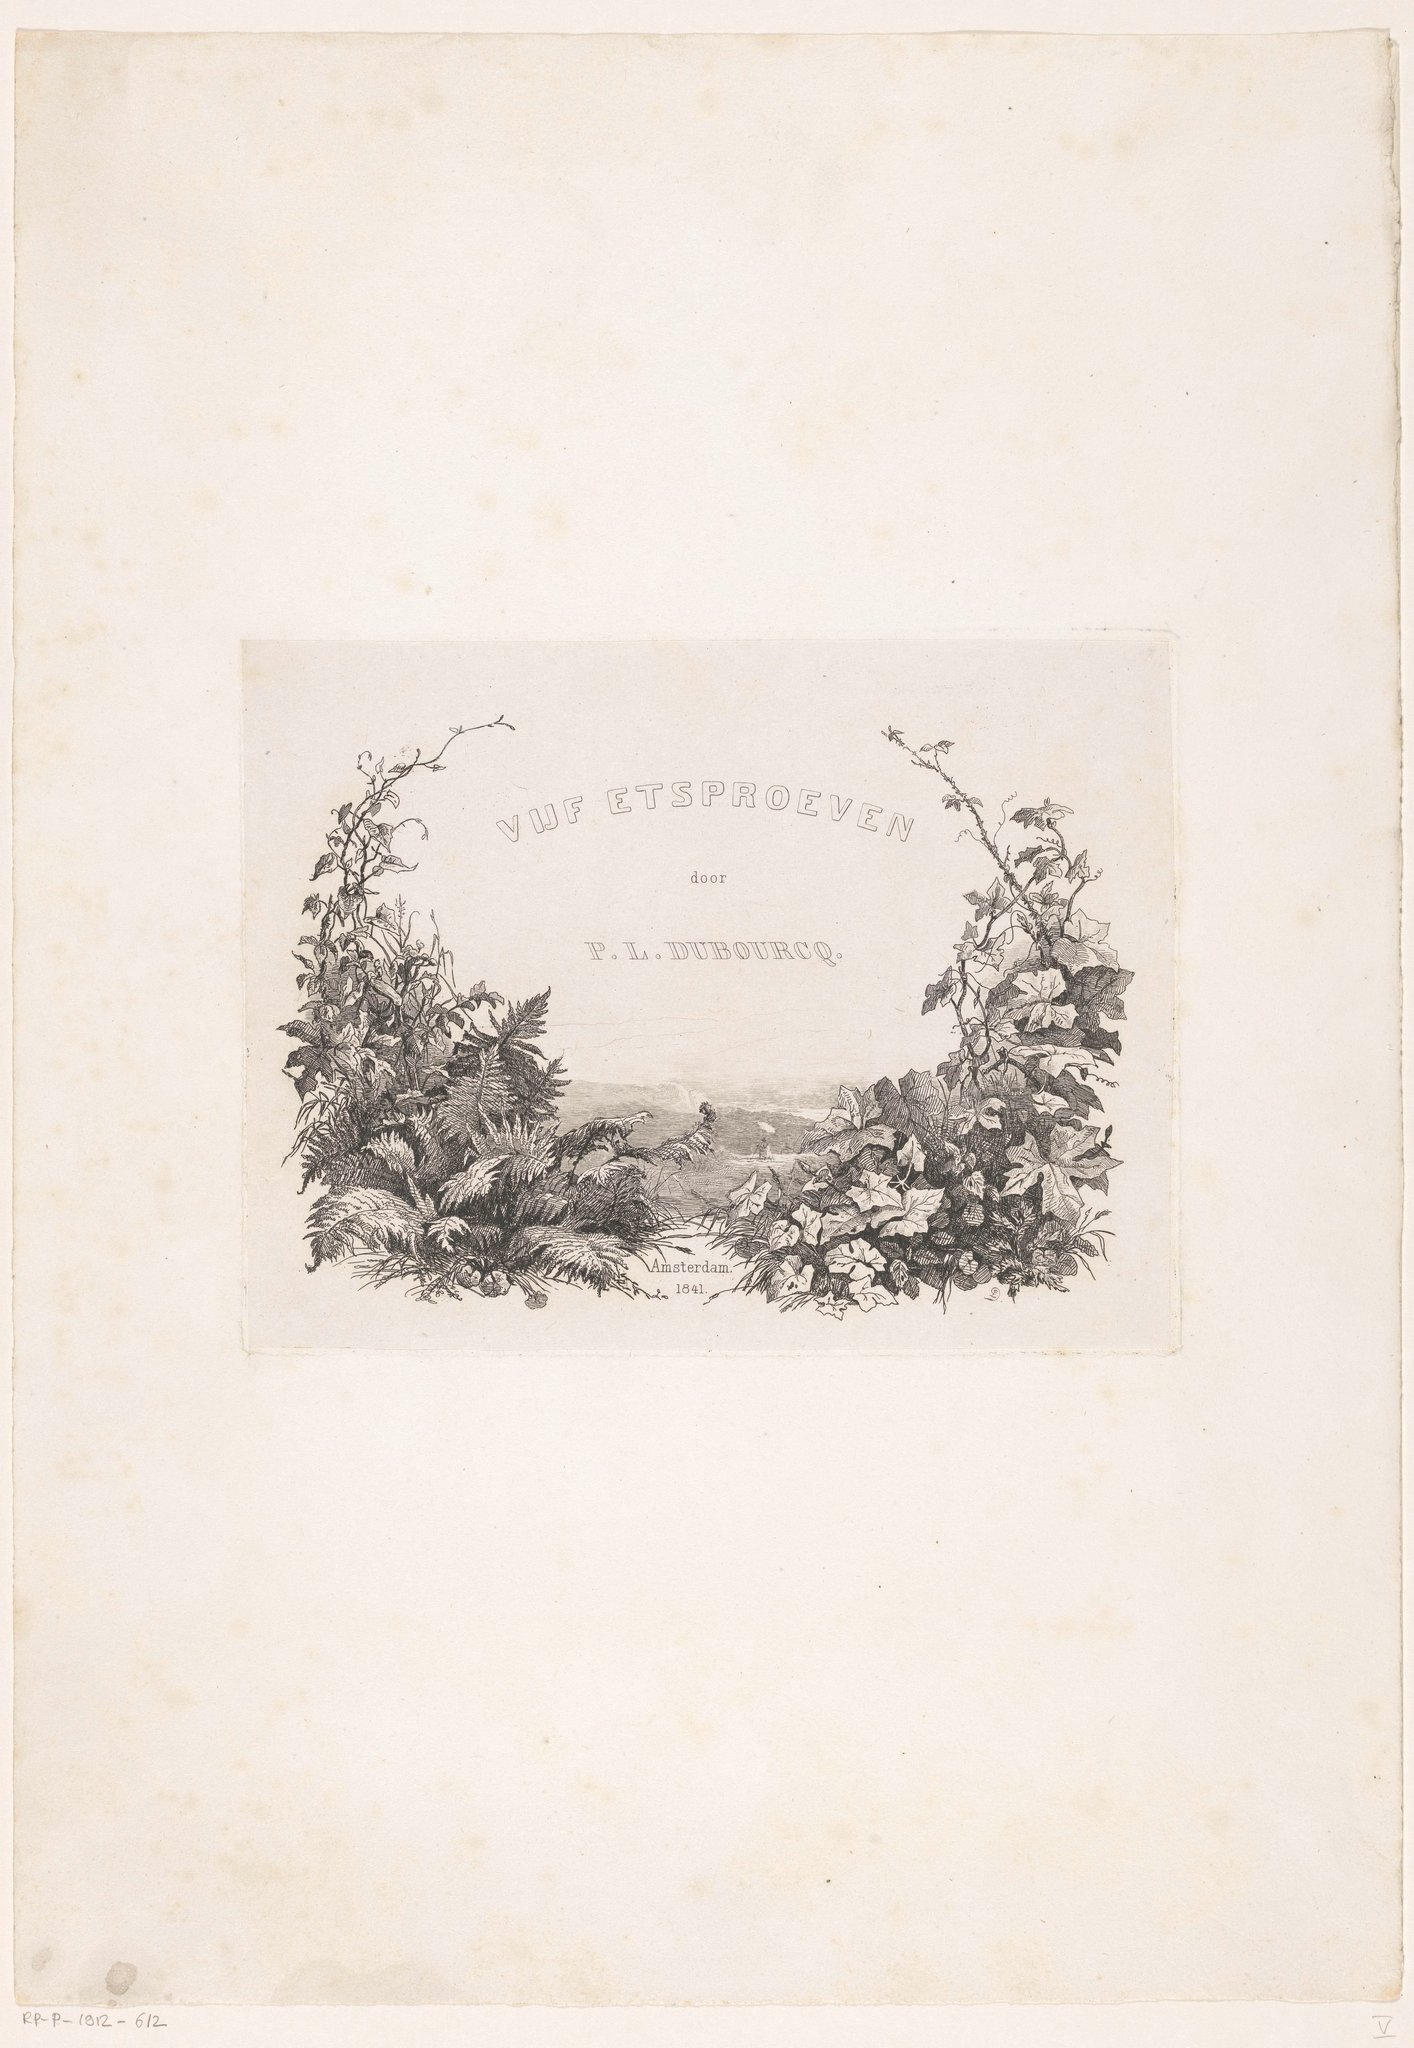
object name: print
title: Kunstenaar aan het werk in de natuur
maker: pierre louis dubourcq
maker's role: draughtsman, painter, print maker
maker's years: 1815-1873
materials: paper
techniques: etching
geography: netherlands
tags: working situations of artist - bb - out of doors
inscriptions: collector's mark: Lugt 2228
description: Omslagafbeelding voor map met vijf etsproeven. In een landschap zit een kunstenaar onder de bescherming van een parasol te werken naar de natuur. Met een florale rand van varen en klimop.